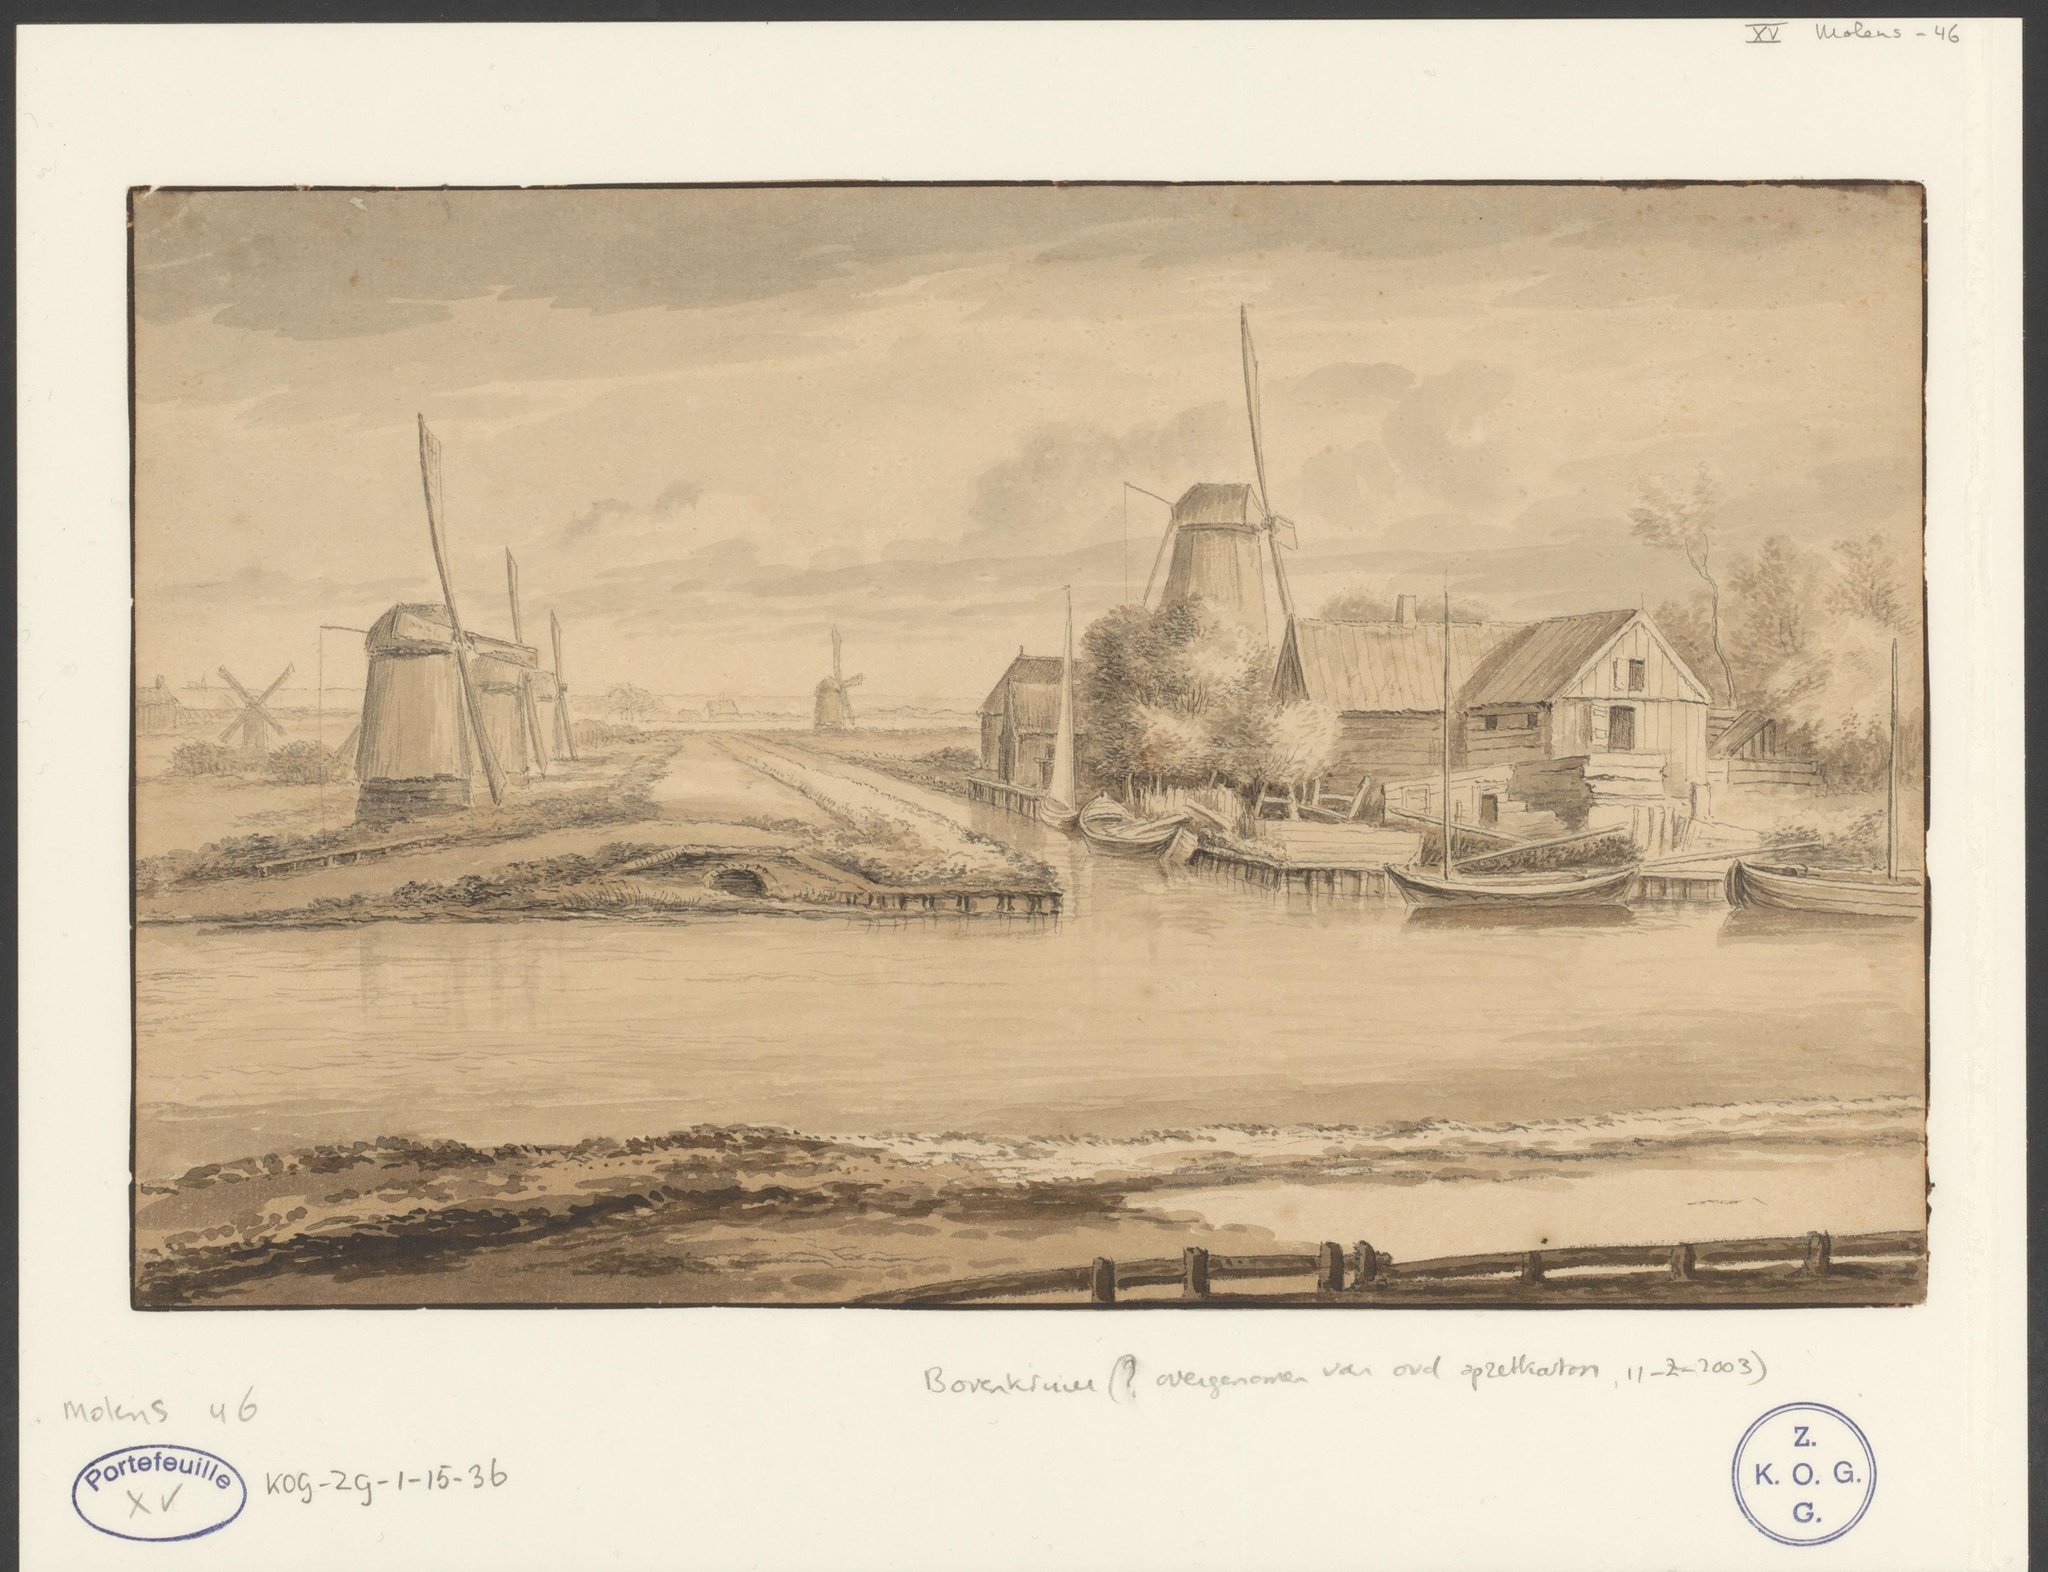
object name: drawing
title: Polderlandschap met molens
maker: Anonymous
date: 1800-1899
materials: chalk, ink, paper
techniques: brush, pen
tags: windmill in landscape, windmill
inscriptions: collector's mark: Lugt 1641, stamp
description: Onderwerpsrubrieken binnen de Atlas Zeden en Gewoonten: Handel, nijverheid en verkeer, Molens.